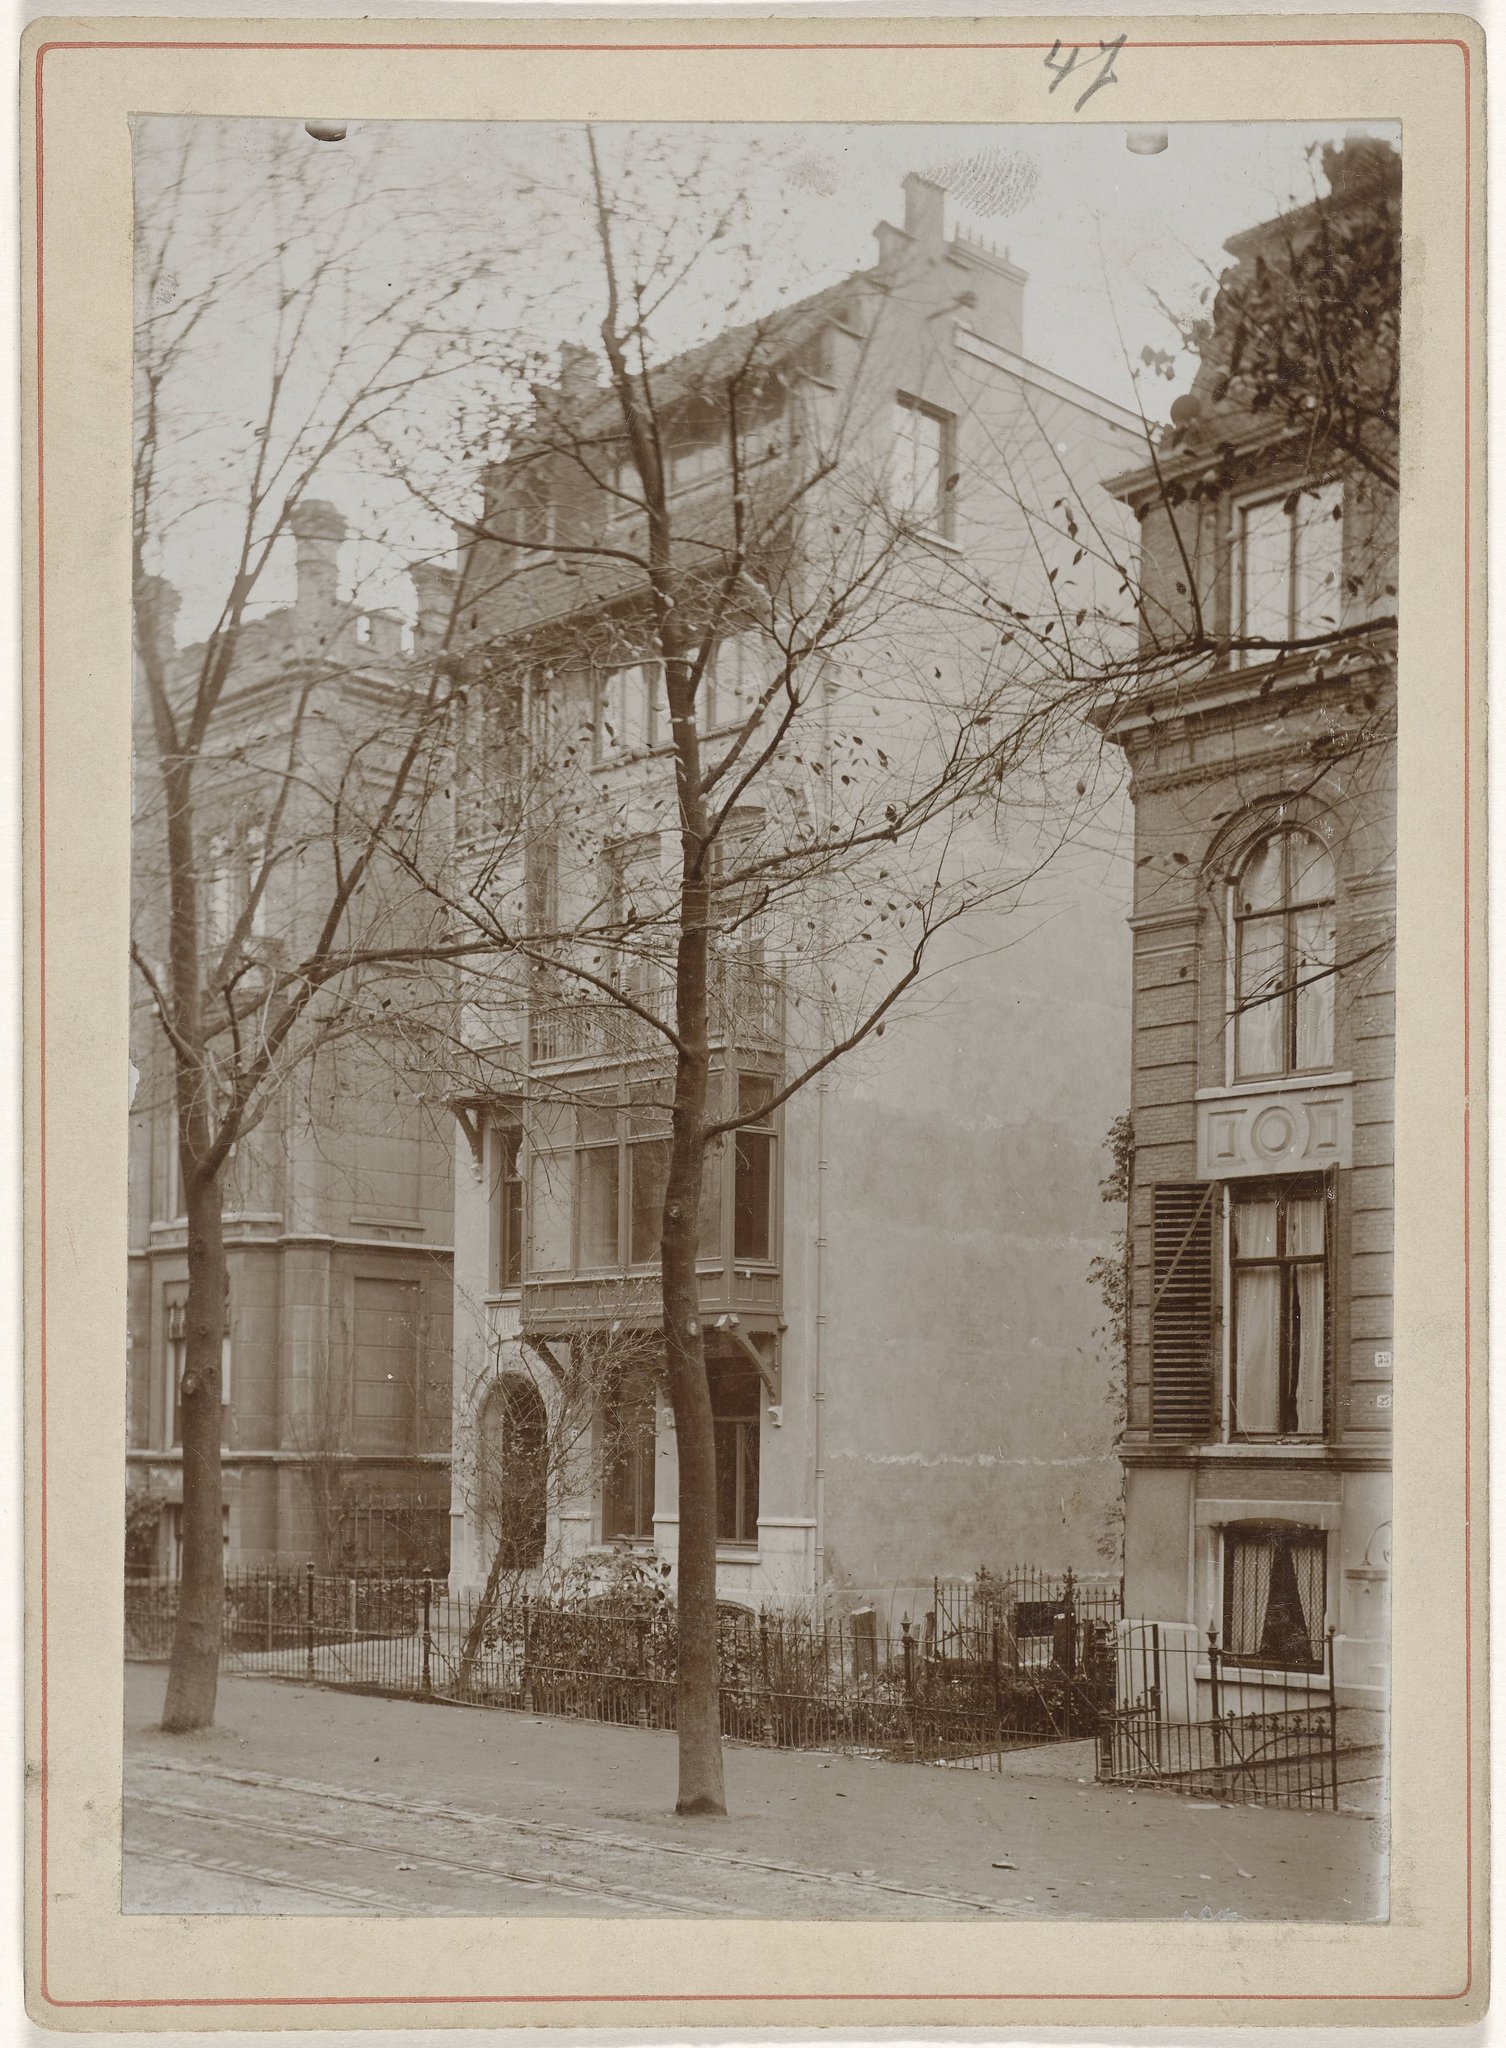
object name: cabinet photograph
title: Woonhuis van Johannes Messchaert en Johanna Jacoba Alma aan Vondelstraat 51 in Amsterdam, ontworpen door Gerrit van Arkel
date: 1899-1900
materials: paper, cardboard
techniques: collodion silver print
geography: amsterdam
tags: urban housing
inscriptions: number: ‘47’